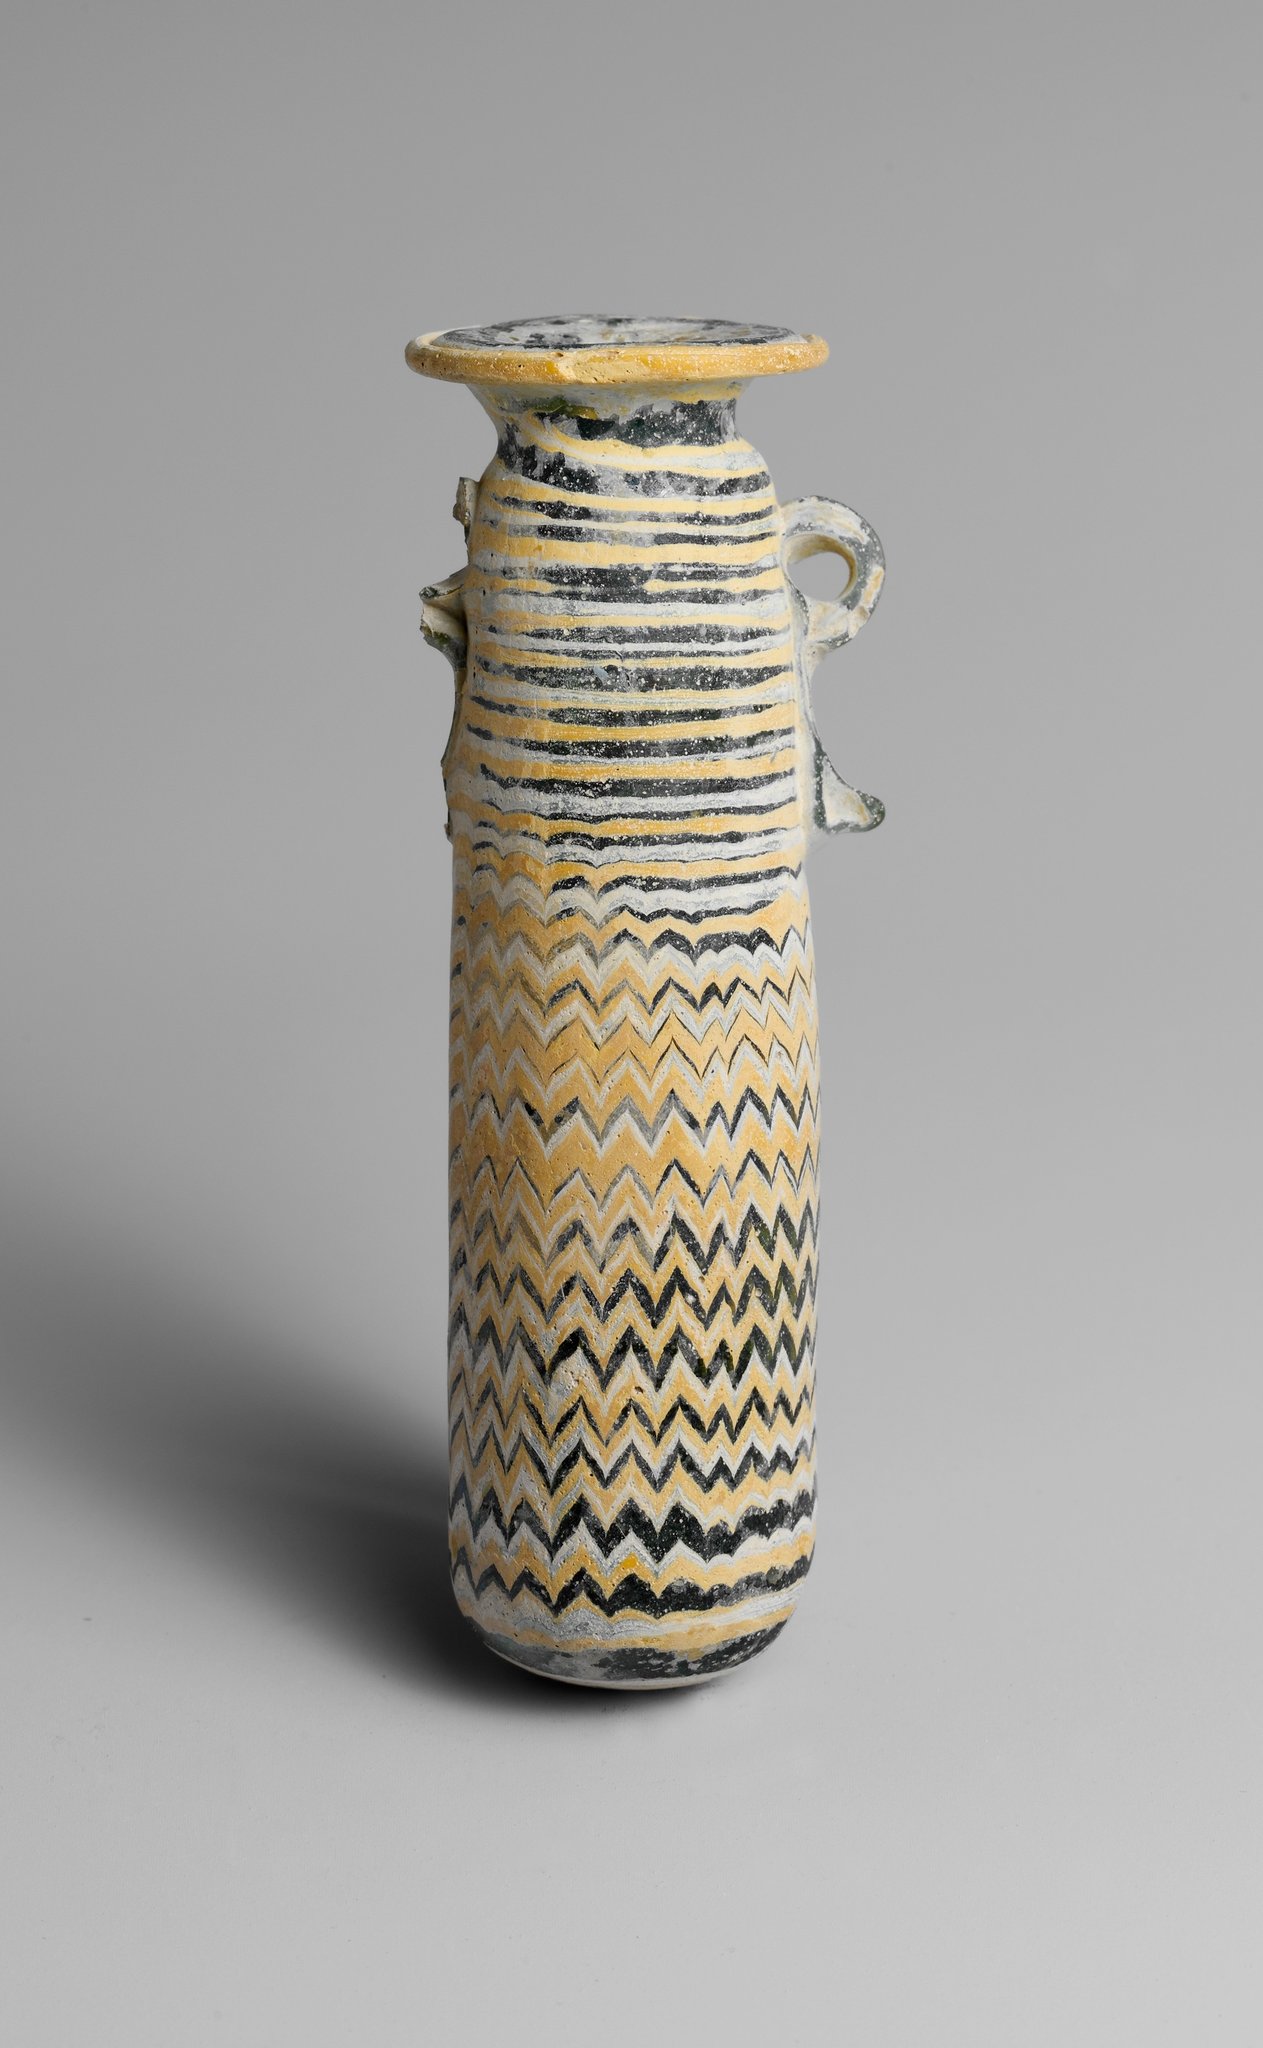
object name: alabastron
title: Glass alabastron (perfume bottle)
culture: greek, eastern mediterranean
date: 500-401 BCE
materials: glass